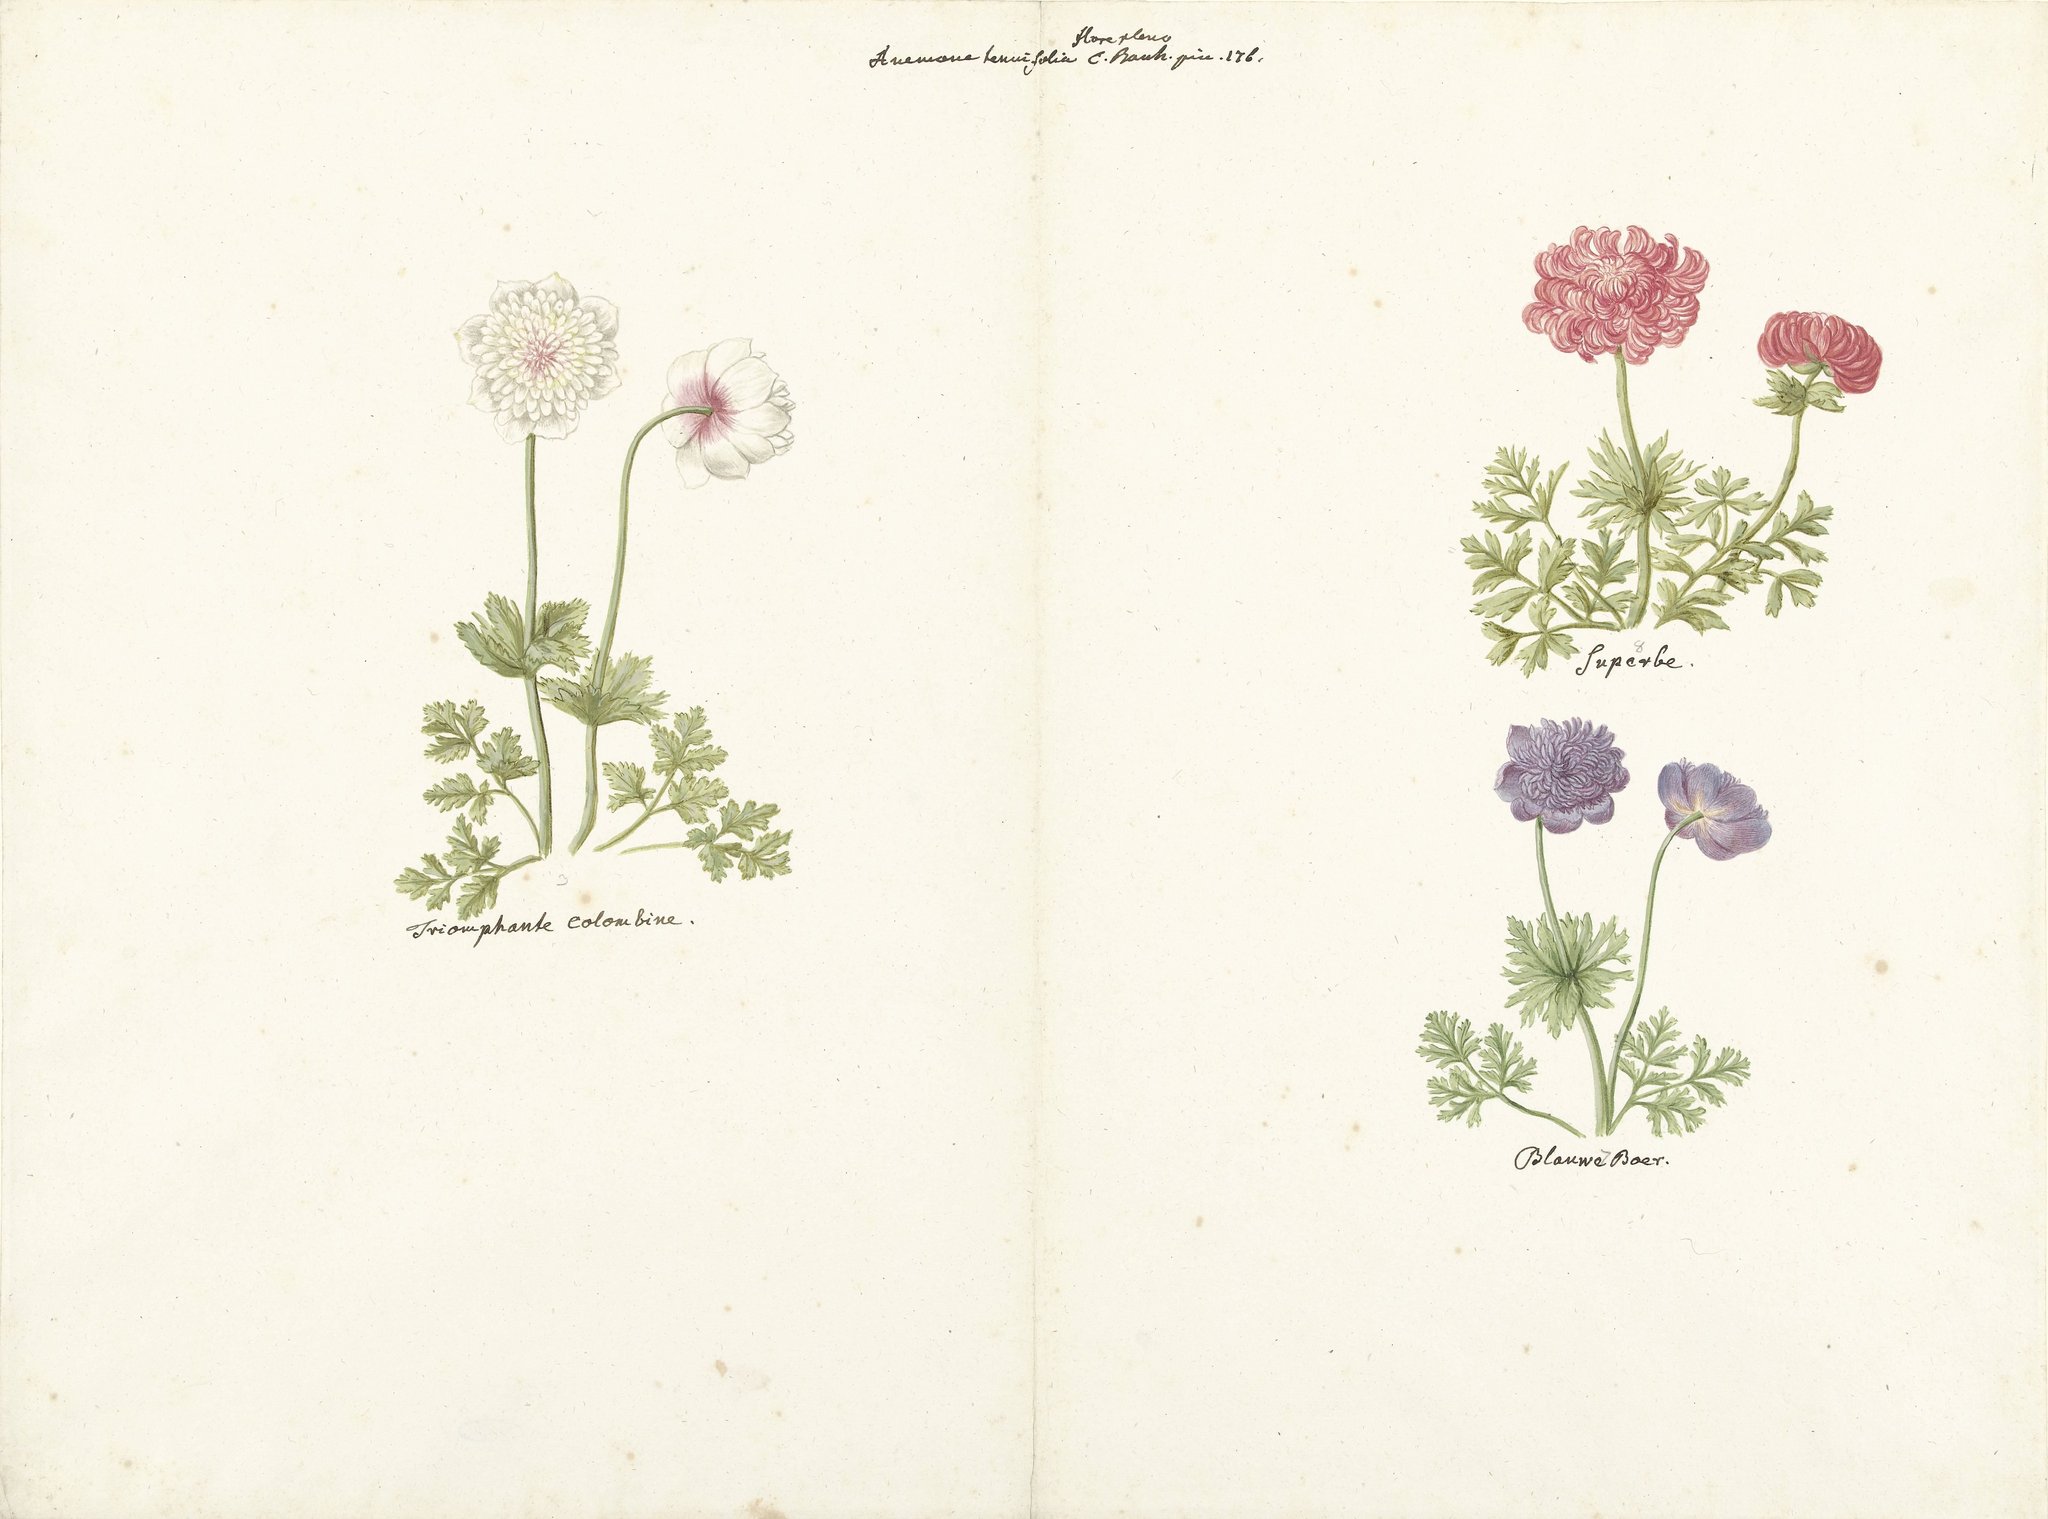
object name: drawing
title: Drie studies van anemonen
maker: c. baak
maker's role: draughtsman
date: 1760-1769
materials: paper, watercolor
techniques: brush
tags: flowers: anemone